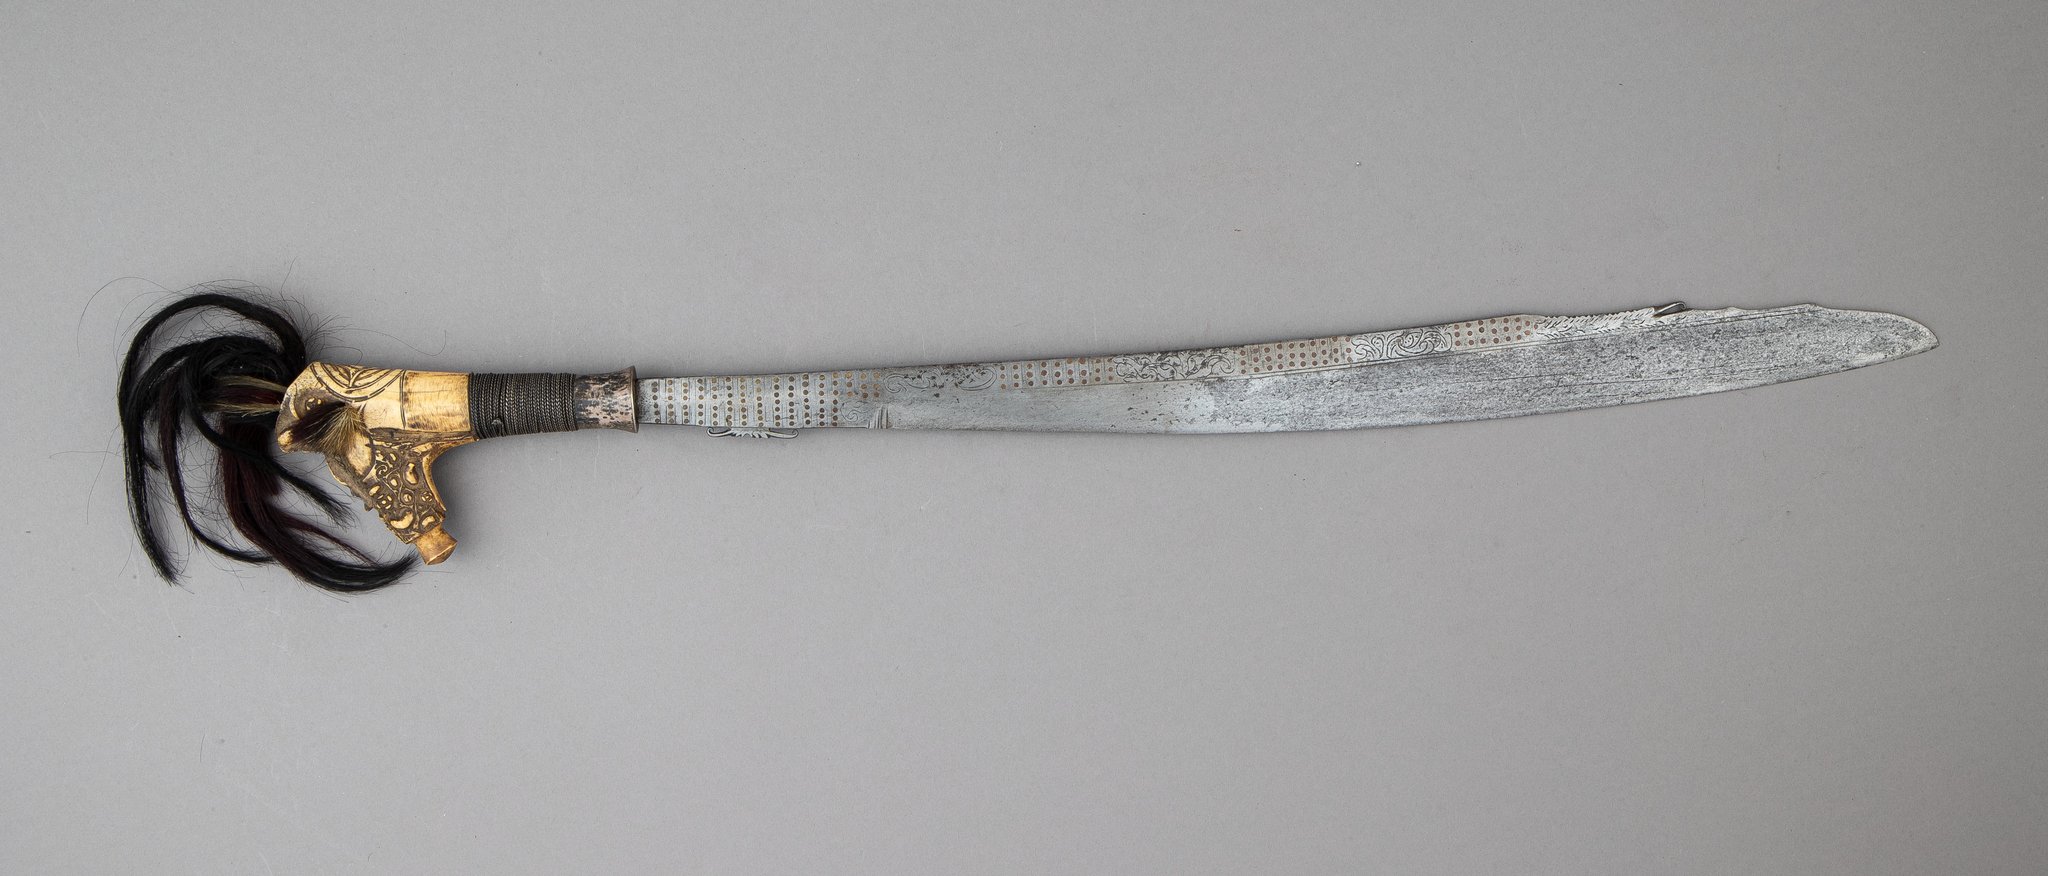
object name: sword mandau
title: Sword (Mandau)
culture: bornean or dyak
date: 1701-1900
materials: brass, hair, horn, wood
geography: borneo